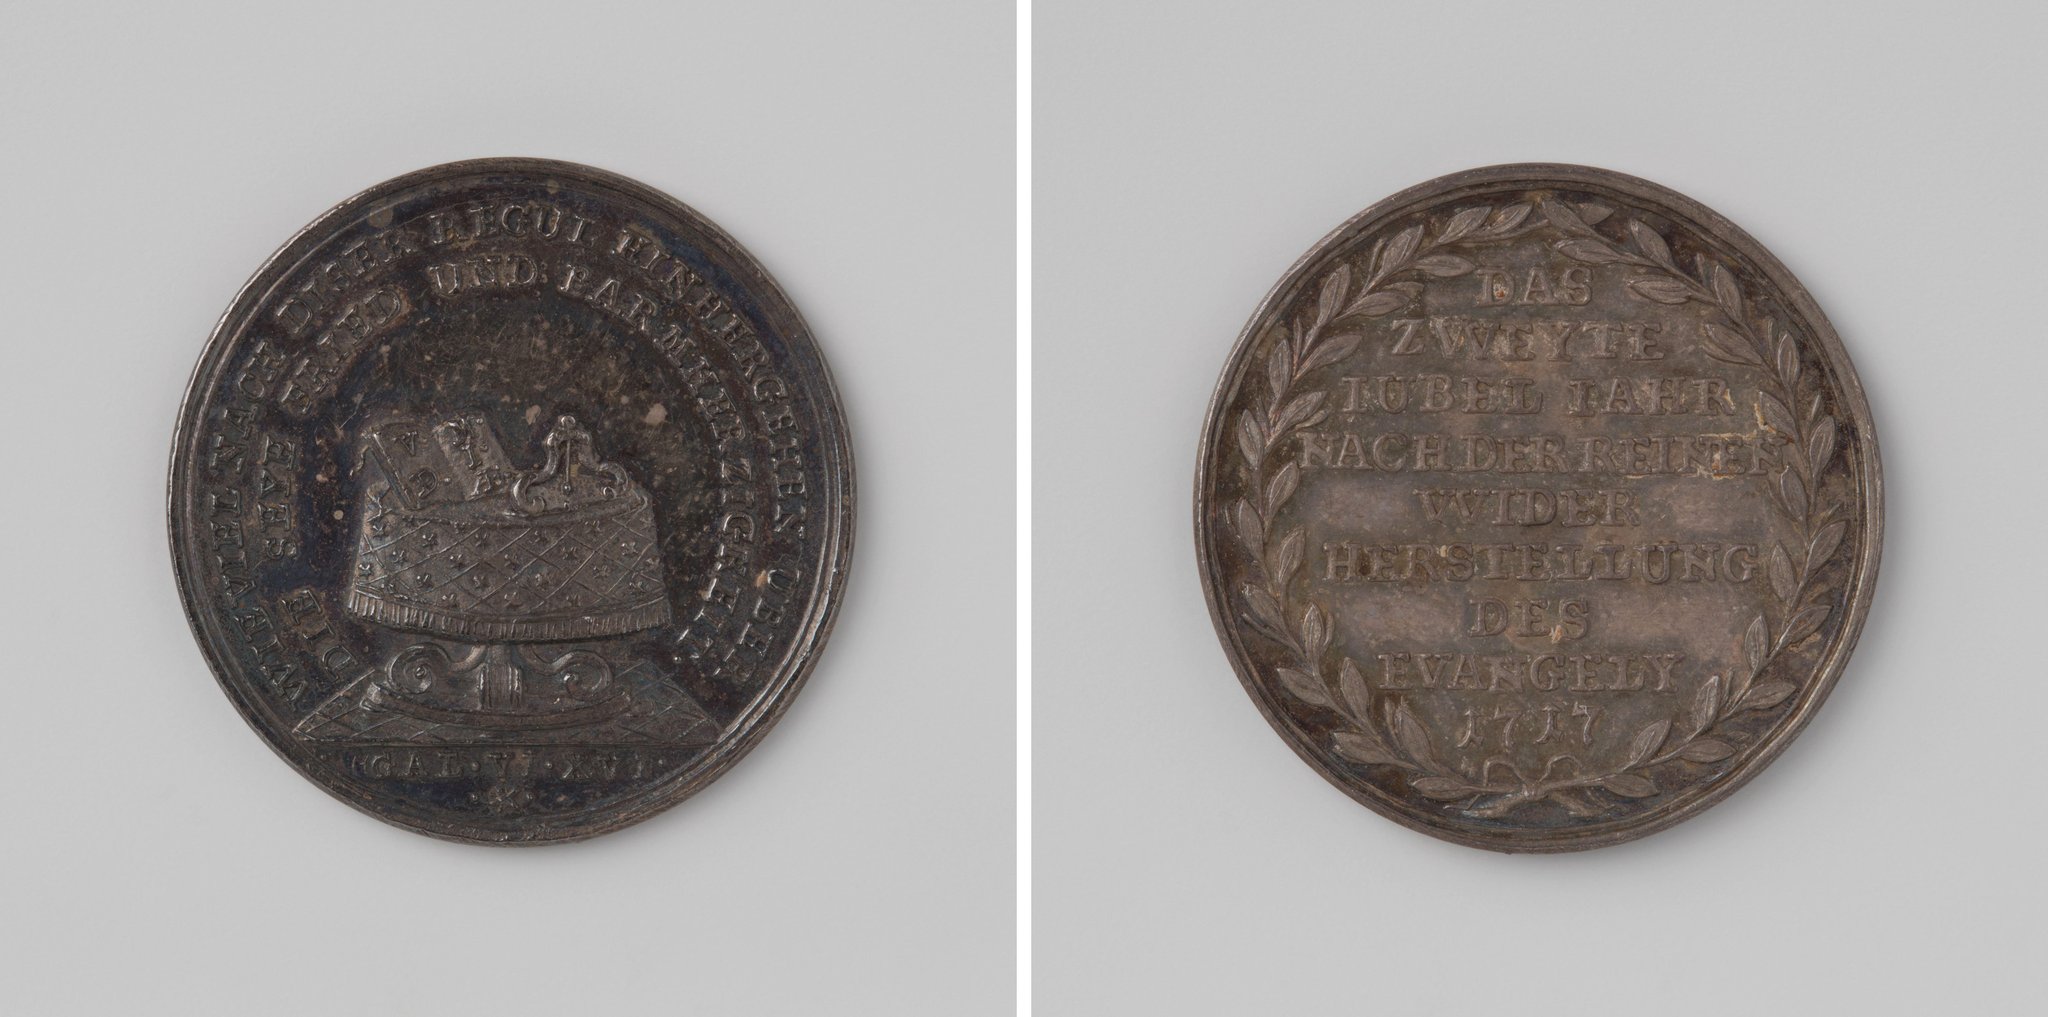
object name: history medal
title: Tweede eeuwfeest van de Reformatie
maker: Anonymous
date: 1717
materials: silver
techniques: striking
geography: germany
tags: priest, martin luther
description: Zilveren penning. Voorzijde: open boek liggend op tafel binnen tweeregelig omschrift; afsnede: opschrift. Keerzijde: opschrift binnen krans van twee samengebonden olijftakken